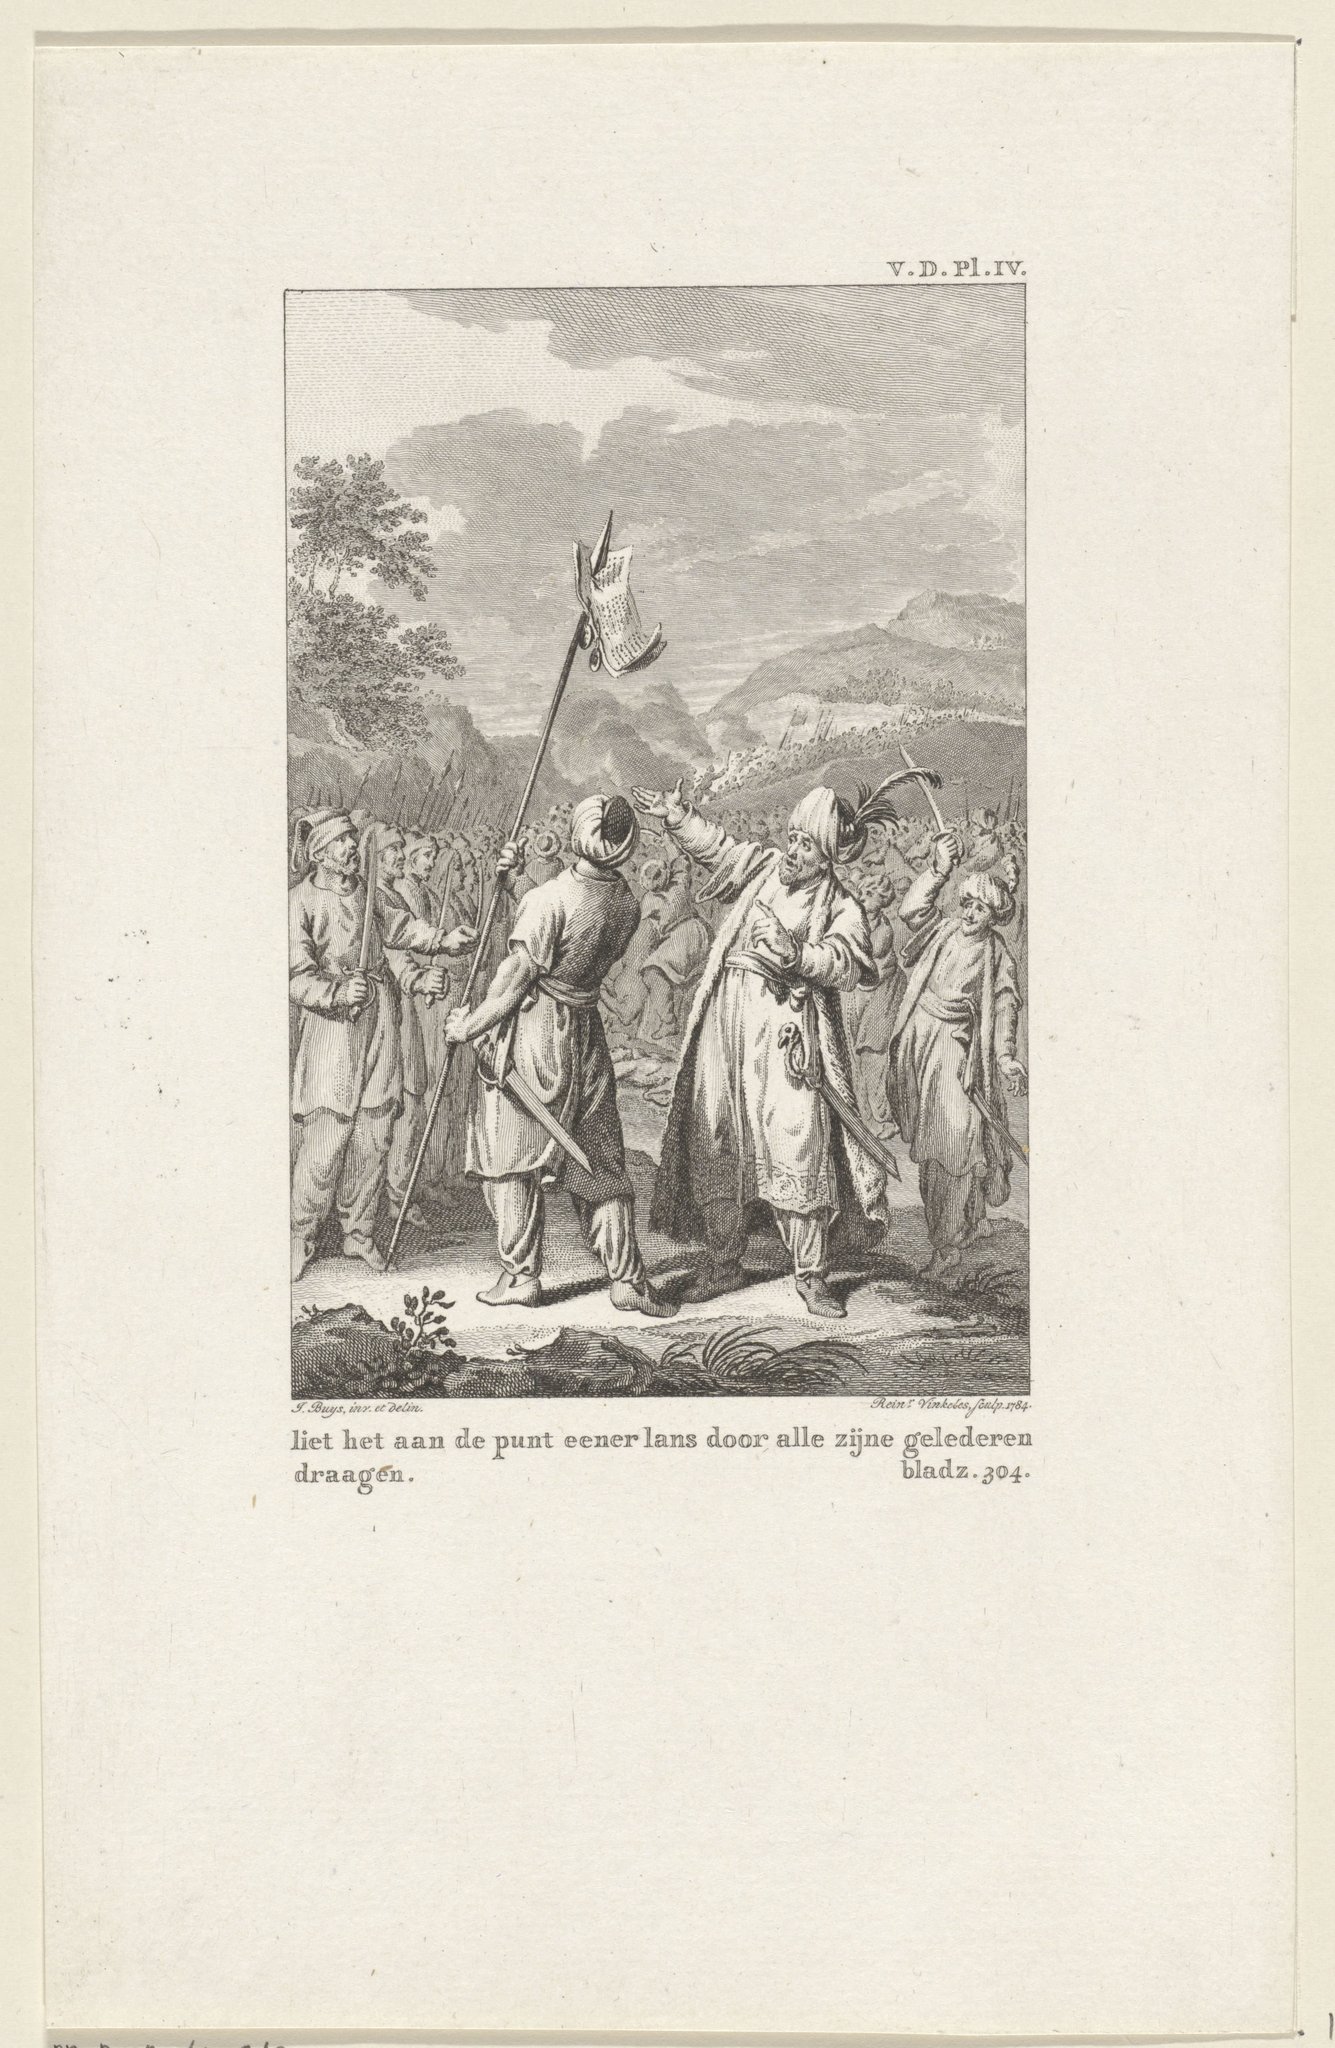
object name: print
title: Murat II rijgt een vredesdocument aan een lans tijdens de slag bij Varna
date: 1784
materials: paper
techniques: engraving, etching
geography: amsterdam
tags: asiatic races and peoples: turks, seal, stamp, handwriting, written text, casting weapons: spear, head-gear: turban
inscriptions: collector's mark: Lugt 240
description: Murat II, sultan van het Ottomaanse rijk, rijgt een vredesdocument aan een lans tijdens de slag bij Varna, 1444. Rechtsboven: V.D.Pl.III. rechtsonder: bladz.277.